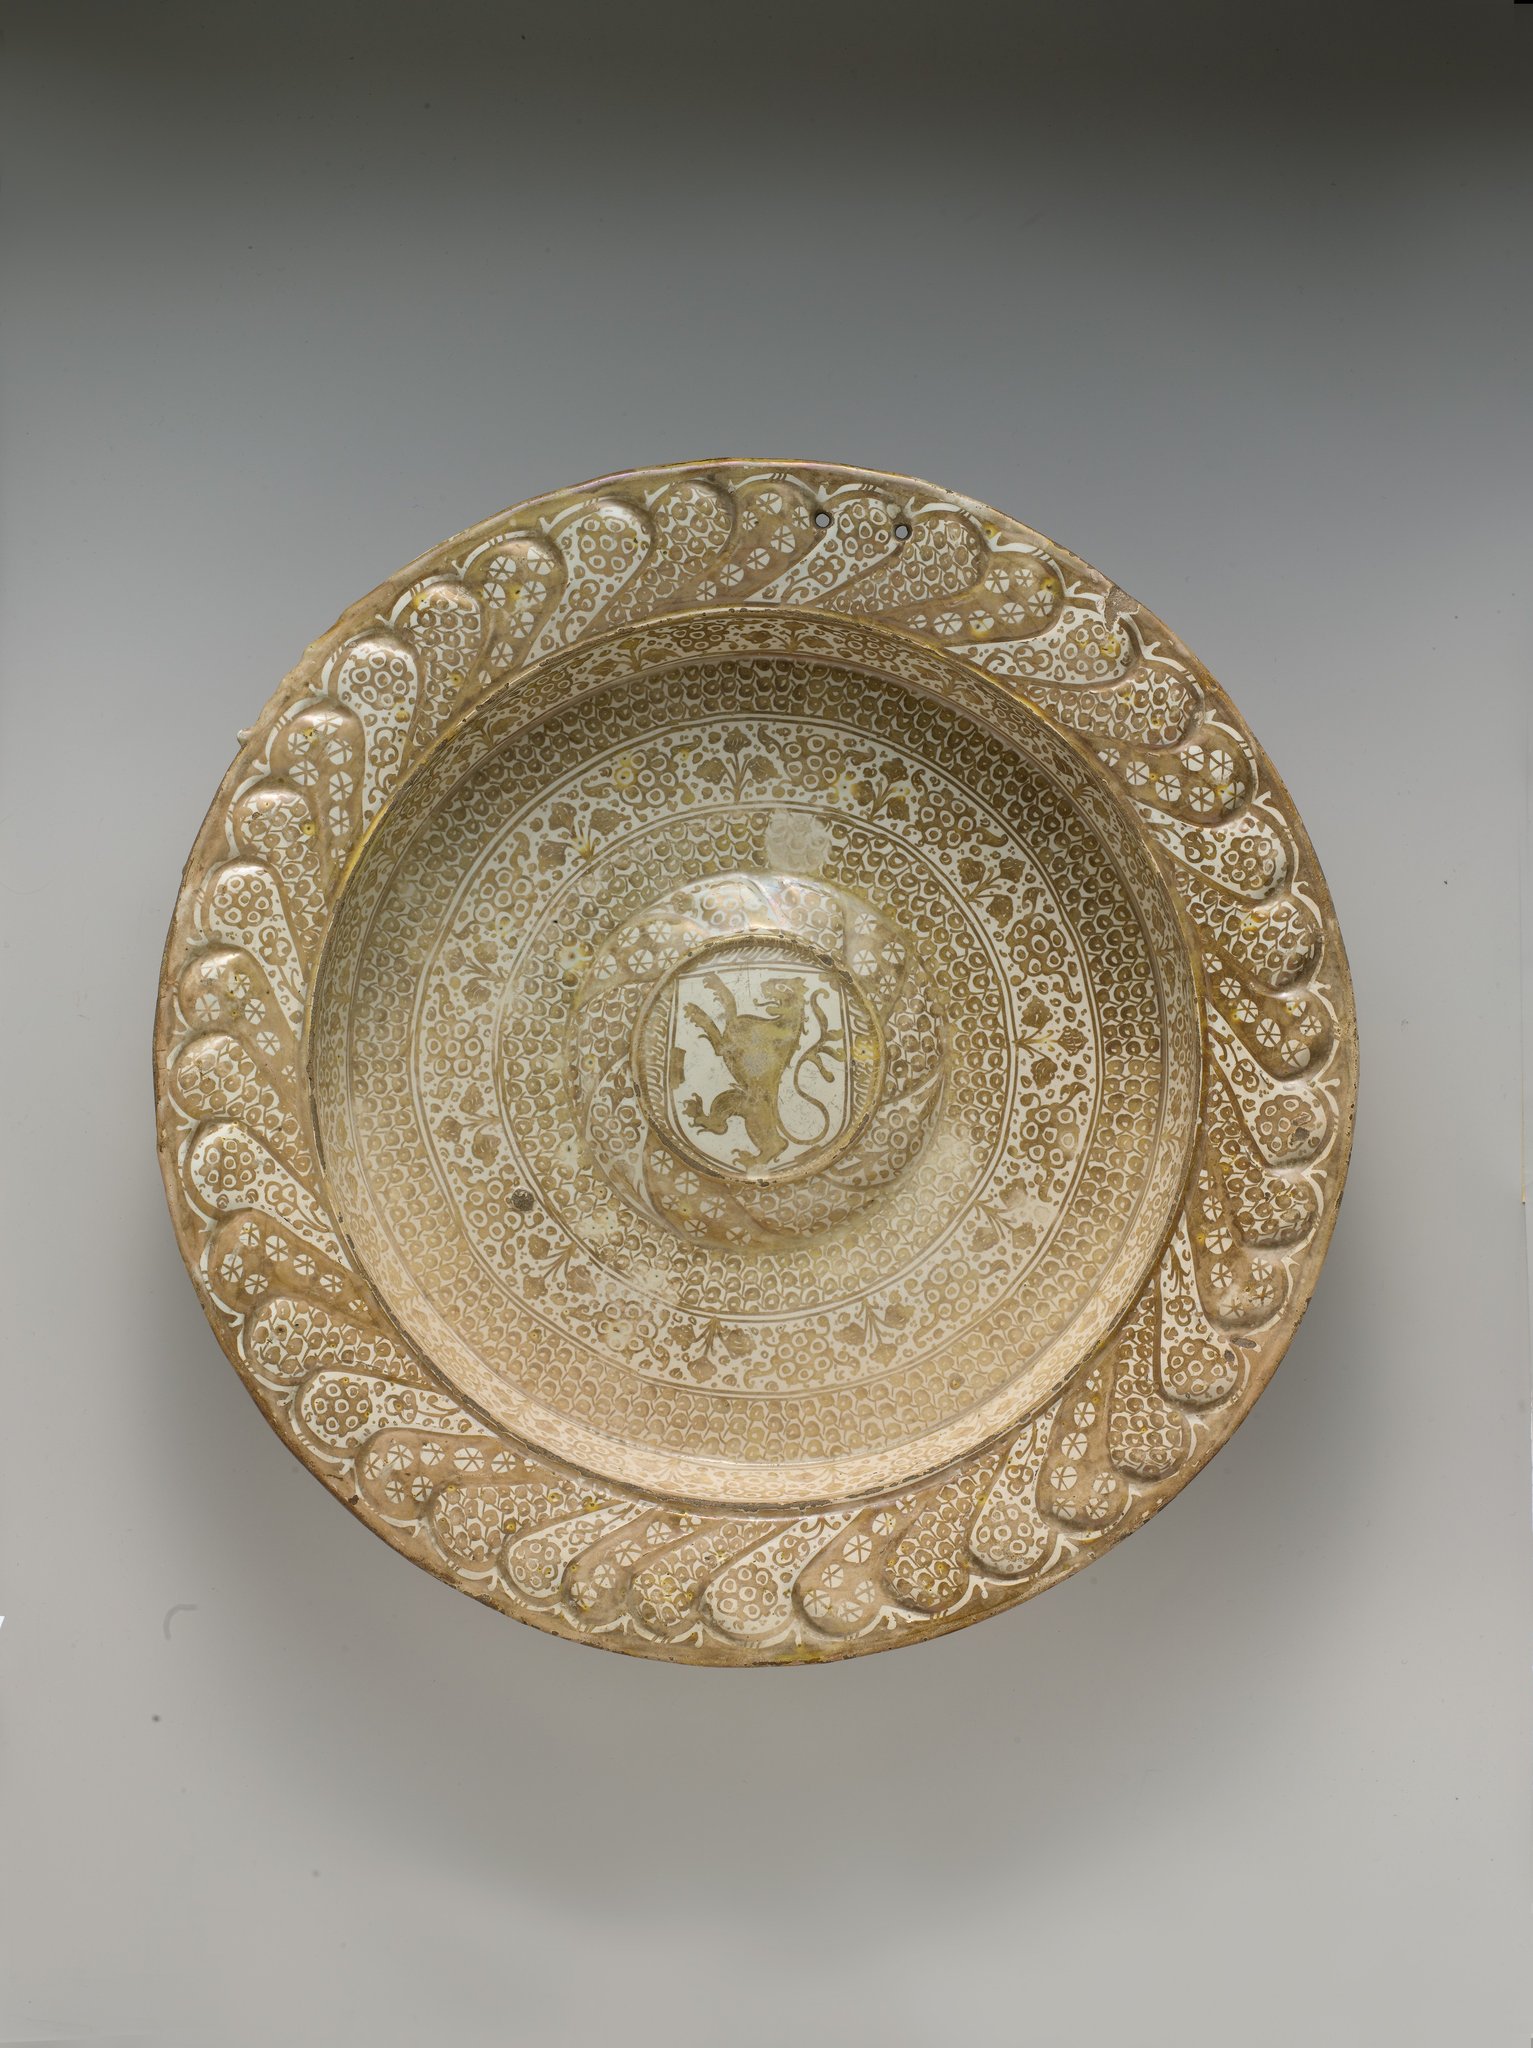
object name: dish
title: Dish (brasero) with Heraldic Lion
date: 1467-1533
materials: earthenware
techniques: luster painting, glazing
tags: lions,flowers,coat of arms